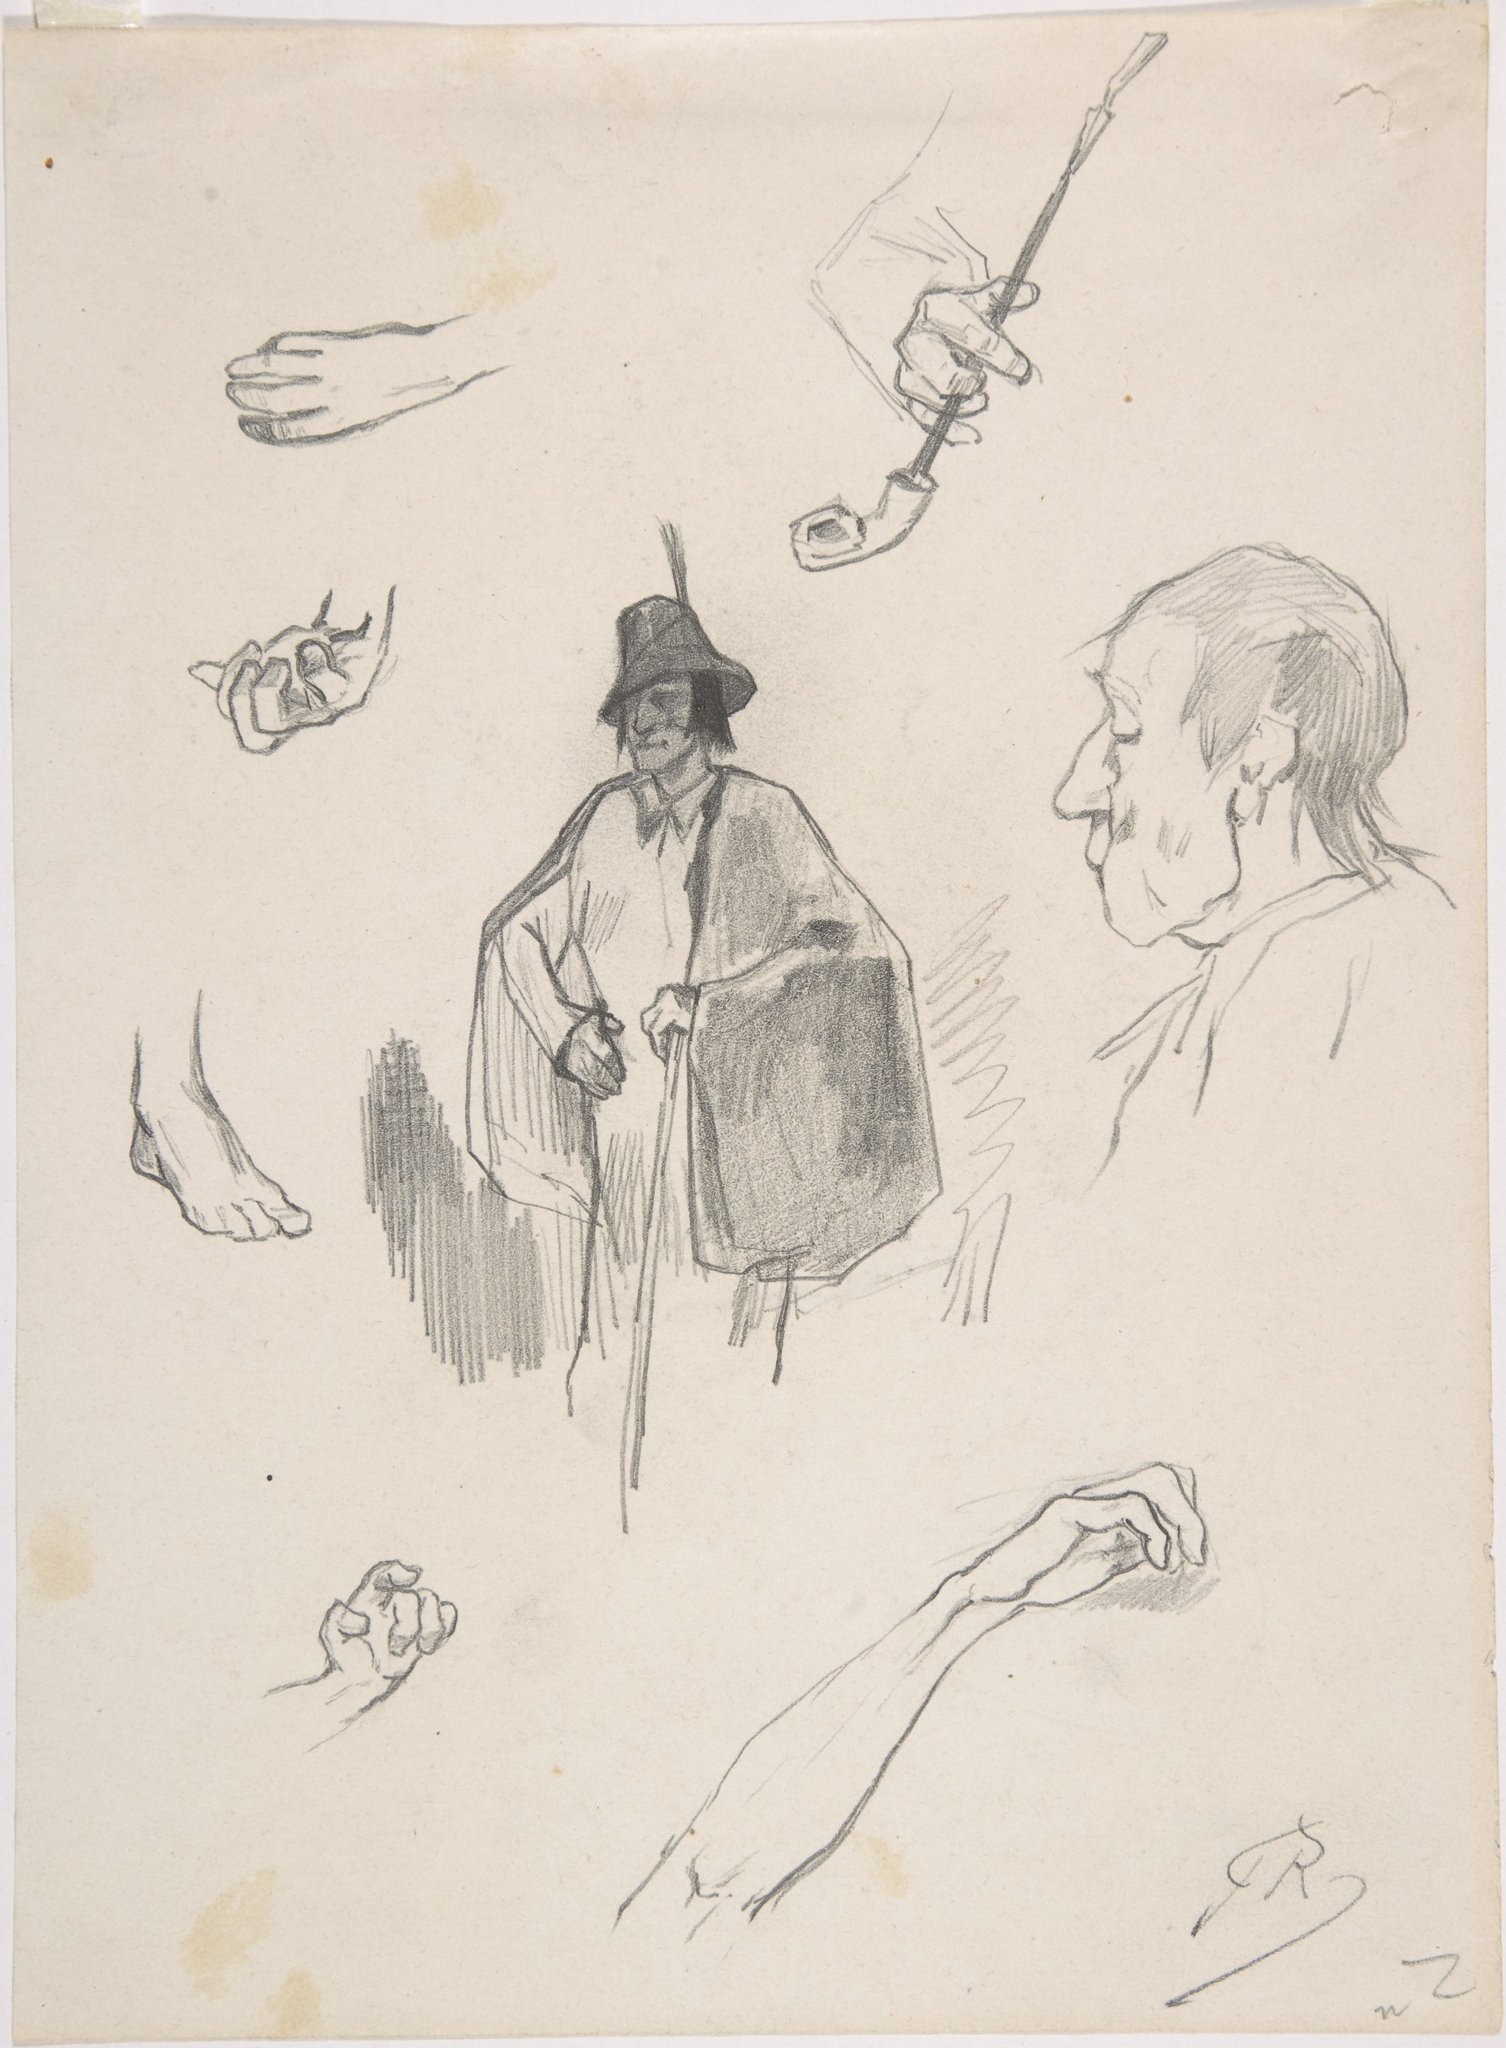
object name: drawing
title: Sheet with figures, details of hands and feet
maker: félicien rops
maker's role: artist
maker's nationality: belgian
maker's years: 1833-1898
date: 1870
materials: graphite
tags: feet,hands,heads,men,profiles